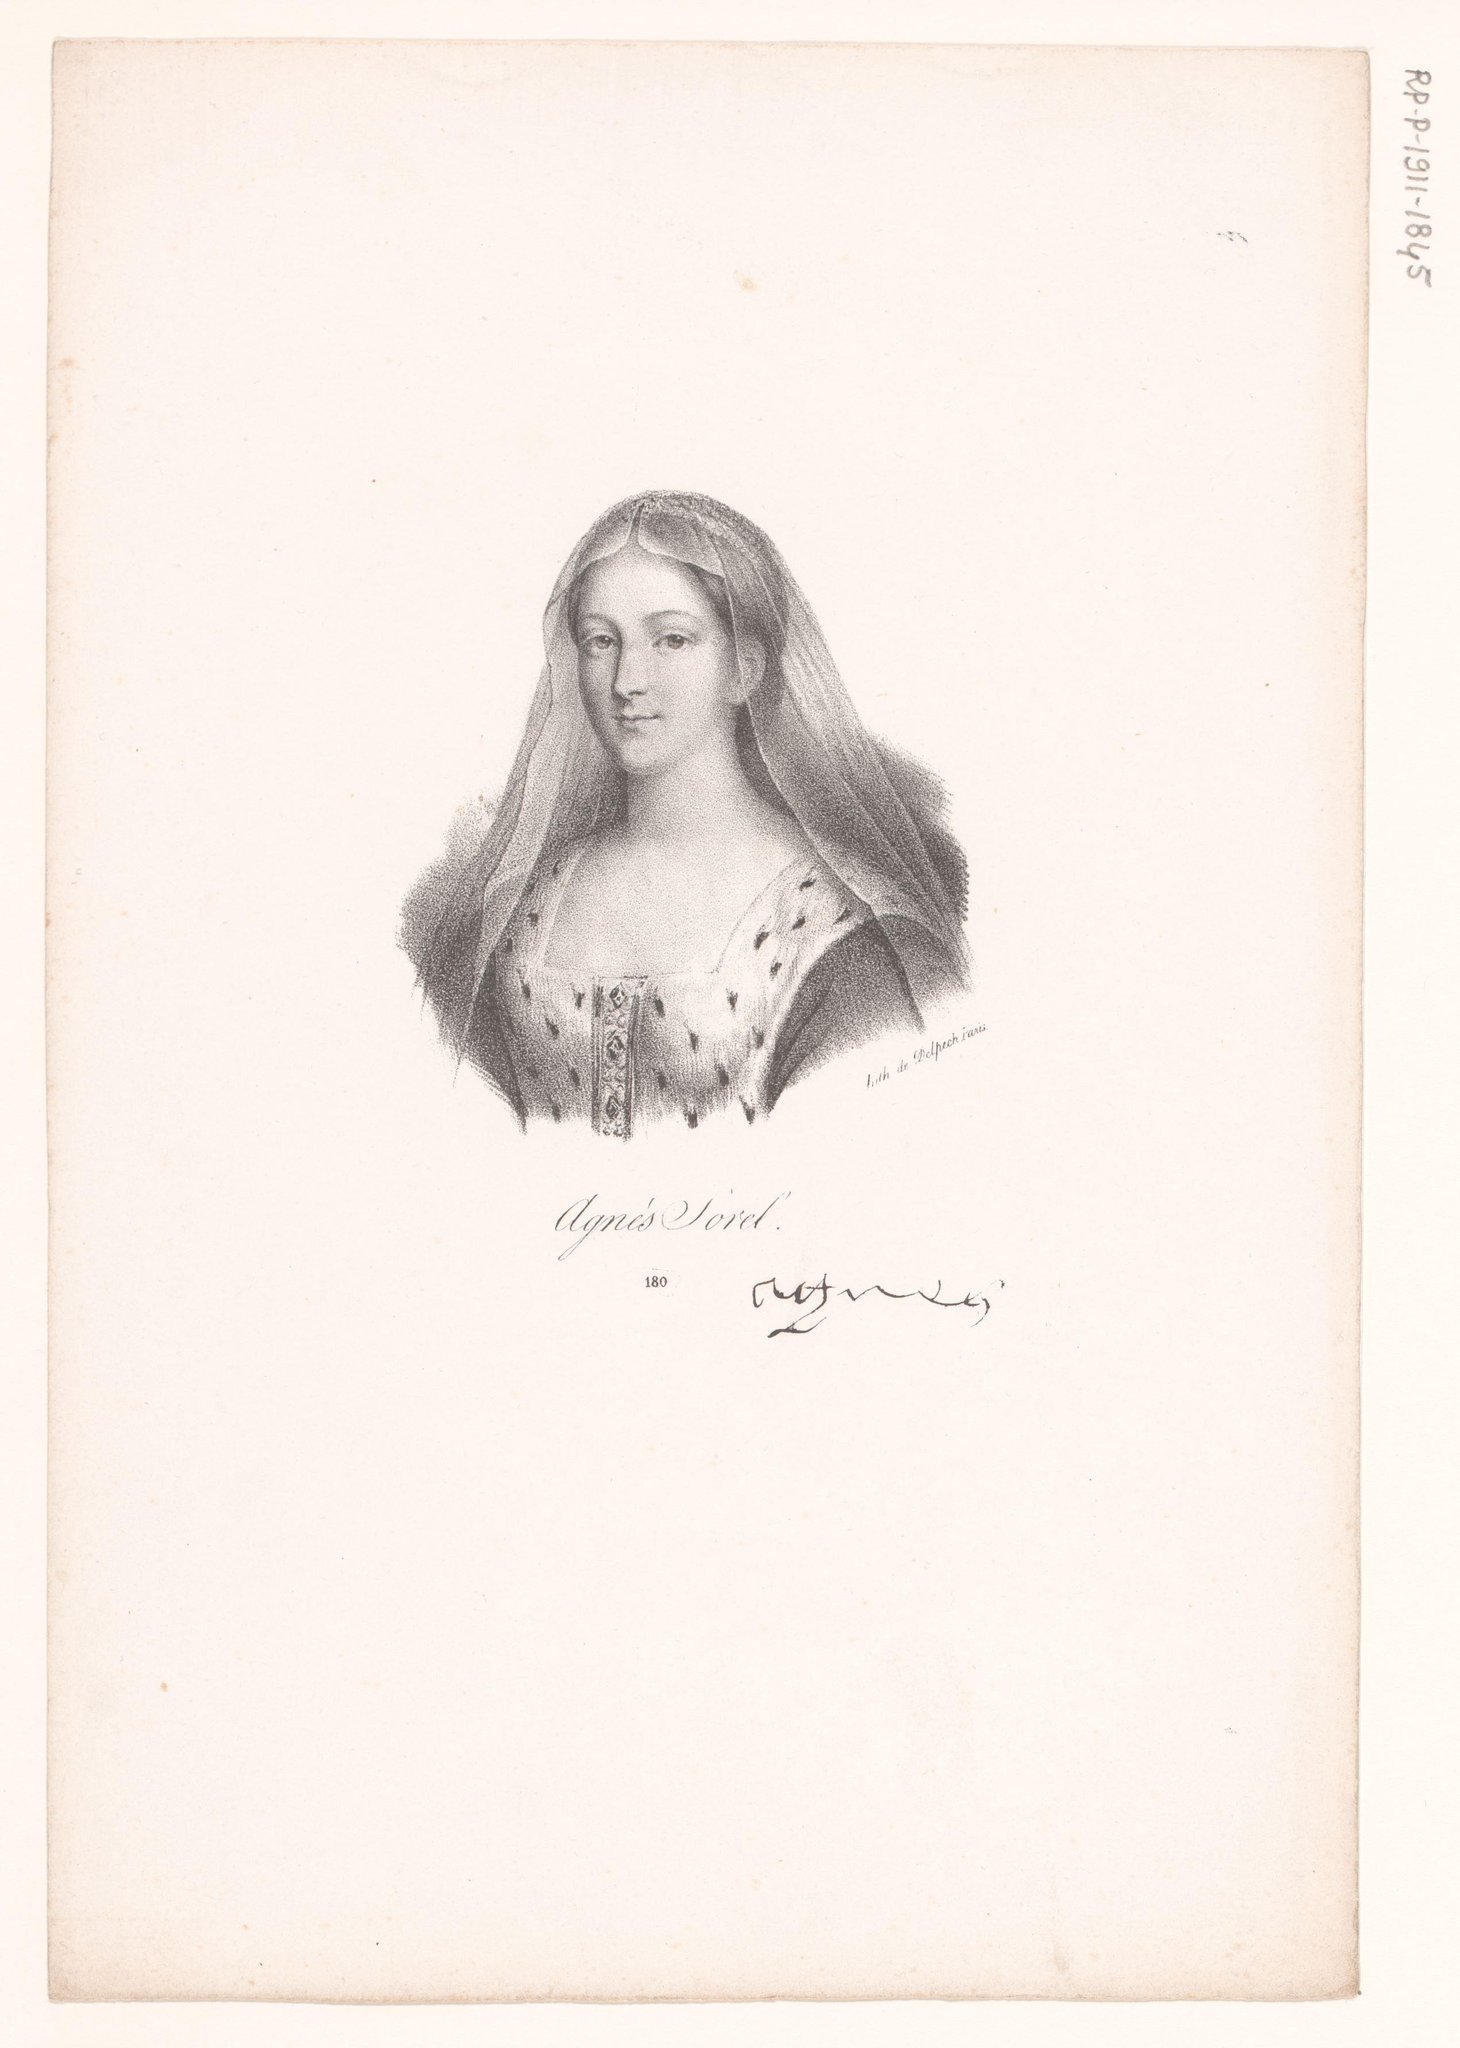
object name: print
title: Portret van Agnès Sorel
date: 1818-1842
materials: paper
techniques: lithograph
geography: paris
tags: historical persons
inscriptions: collector's mark: Lugt 2228a